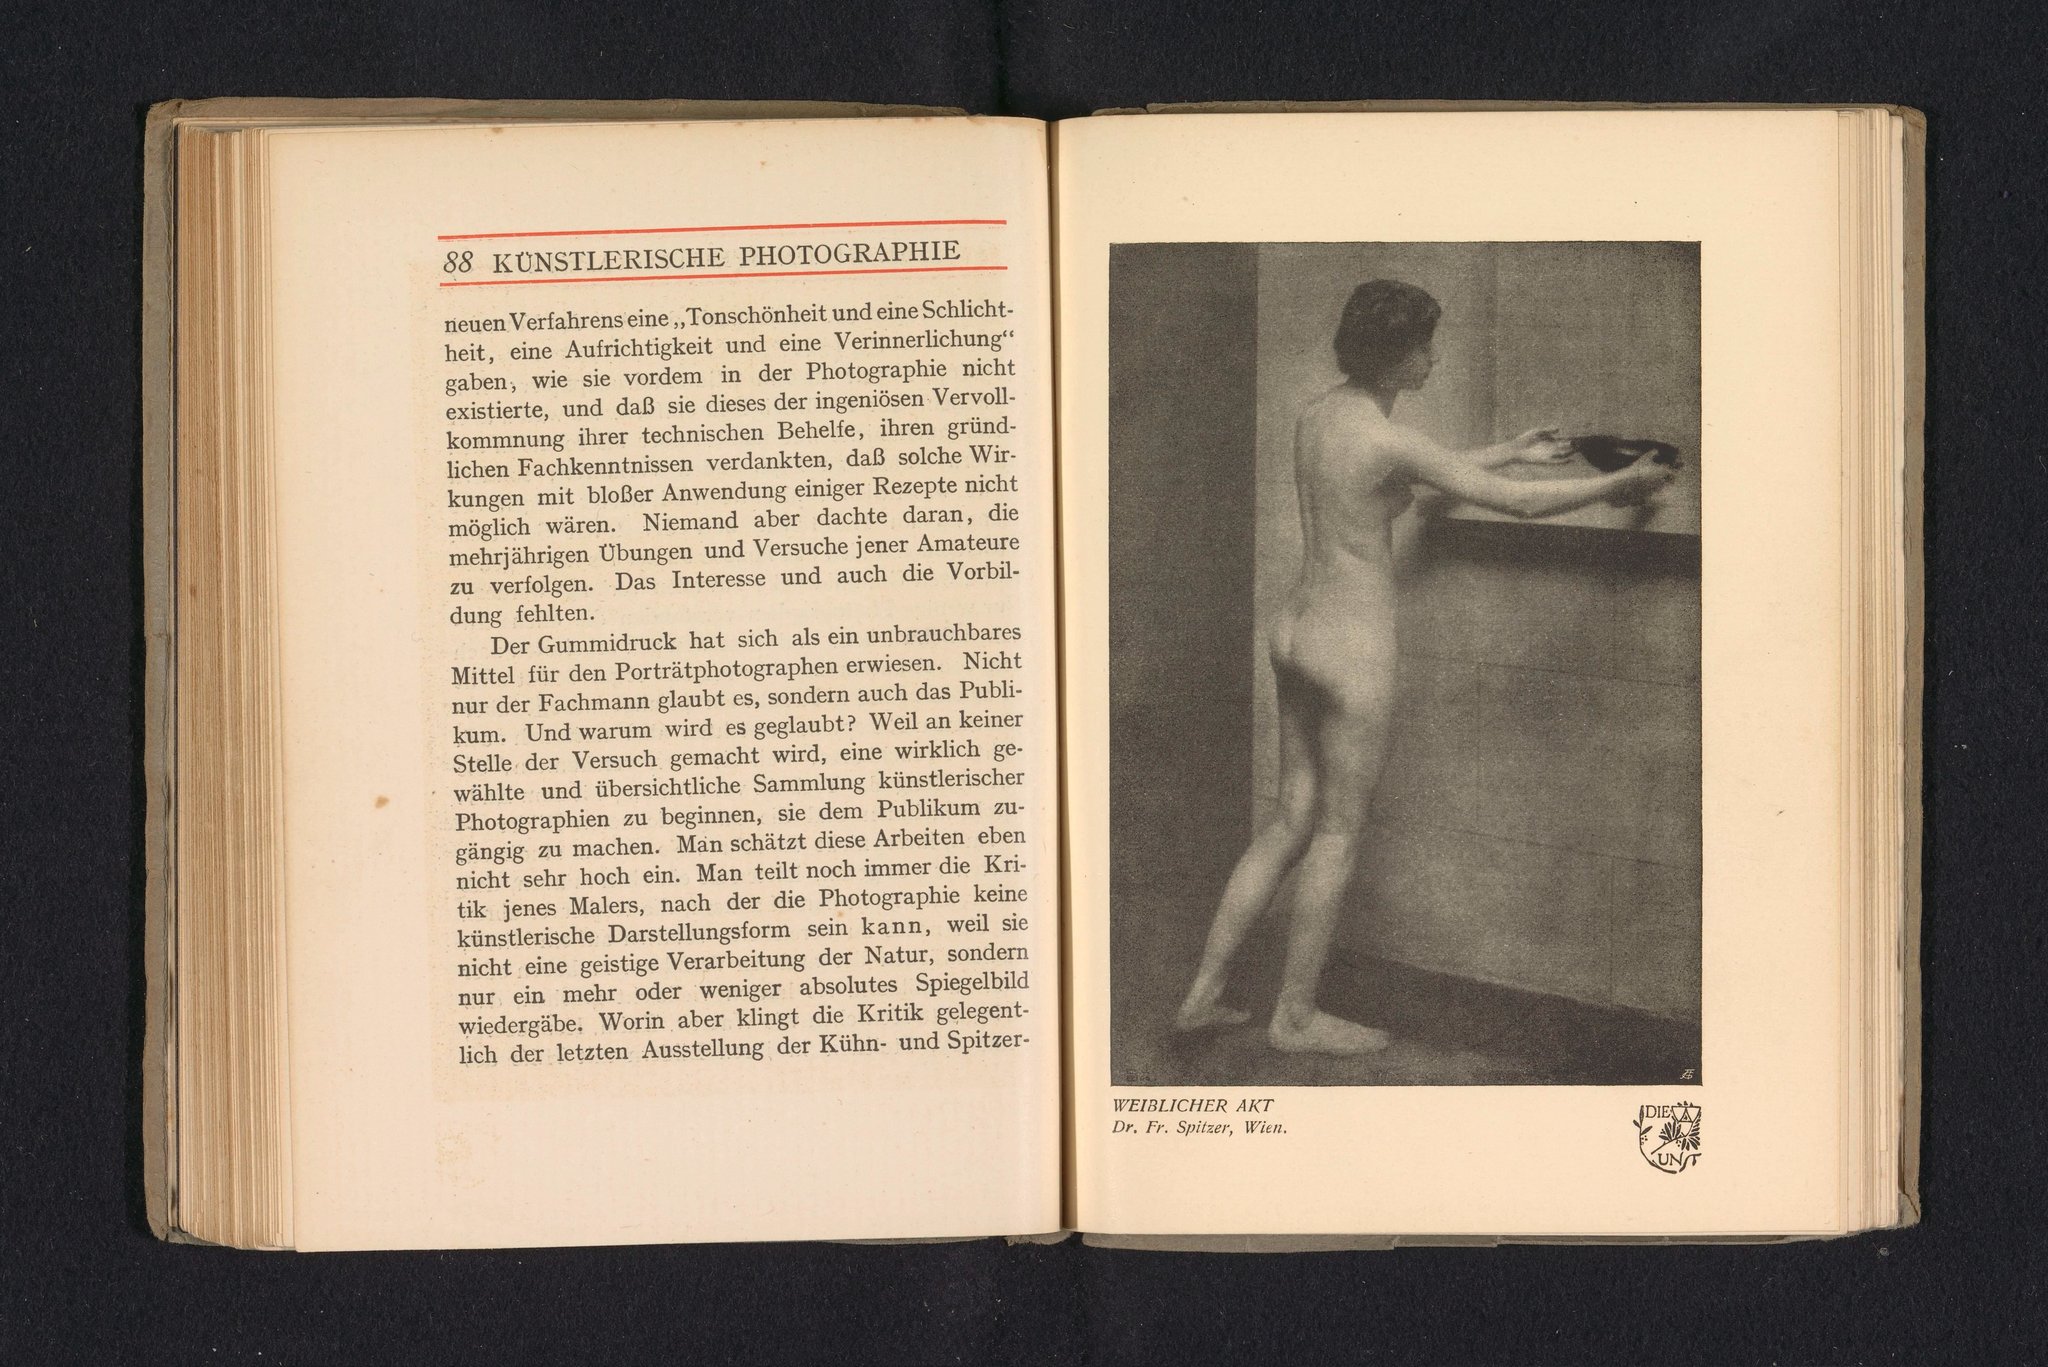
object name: photomechanical print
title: Fotoreproductie van een foto door Friedrich Victor Spitzer, voorstellend een vrouwelijk naakt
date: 1880-1907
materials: paper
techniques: autotype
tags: the (nude) human figure; 'corpo humano' (ripa) - aa - female human figure